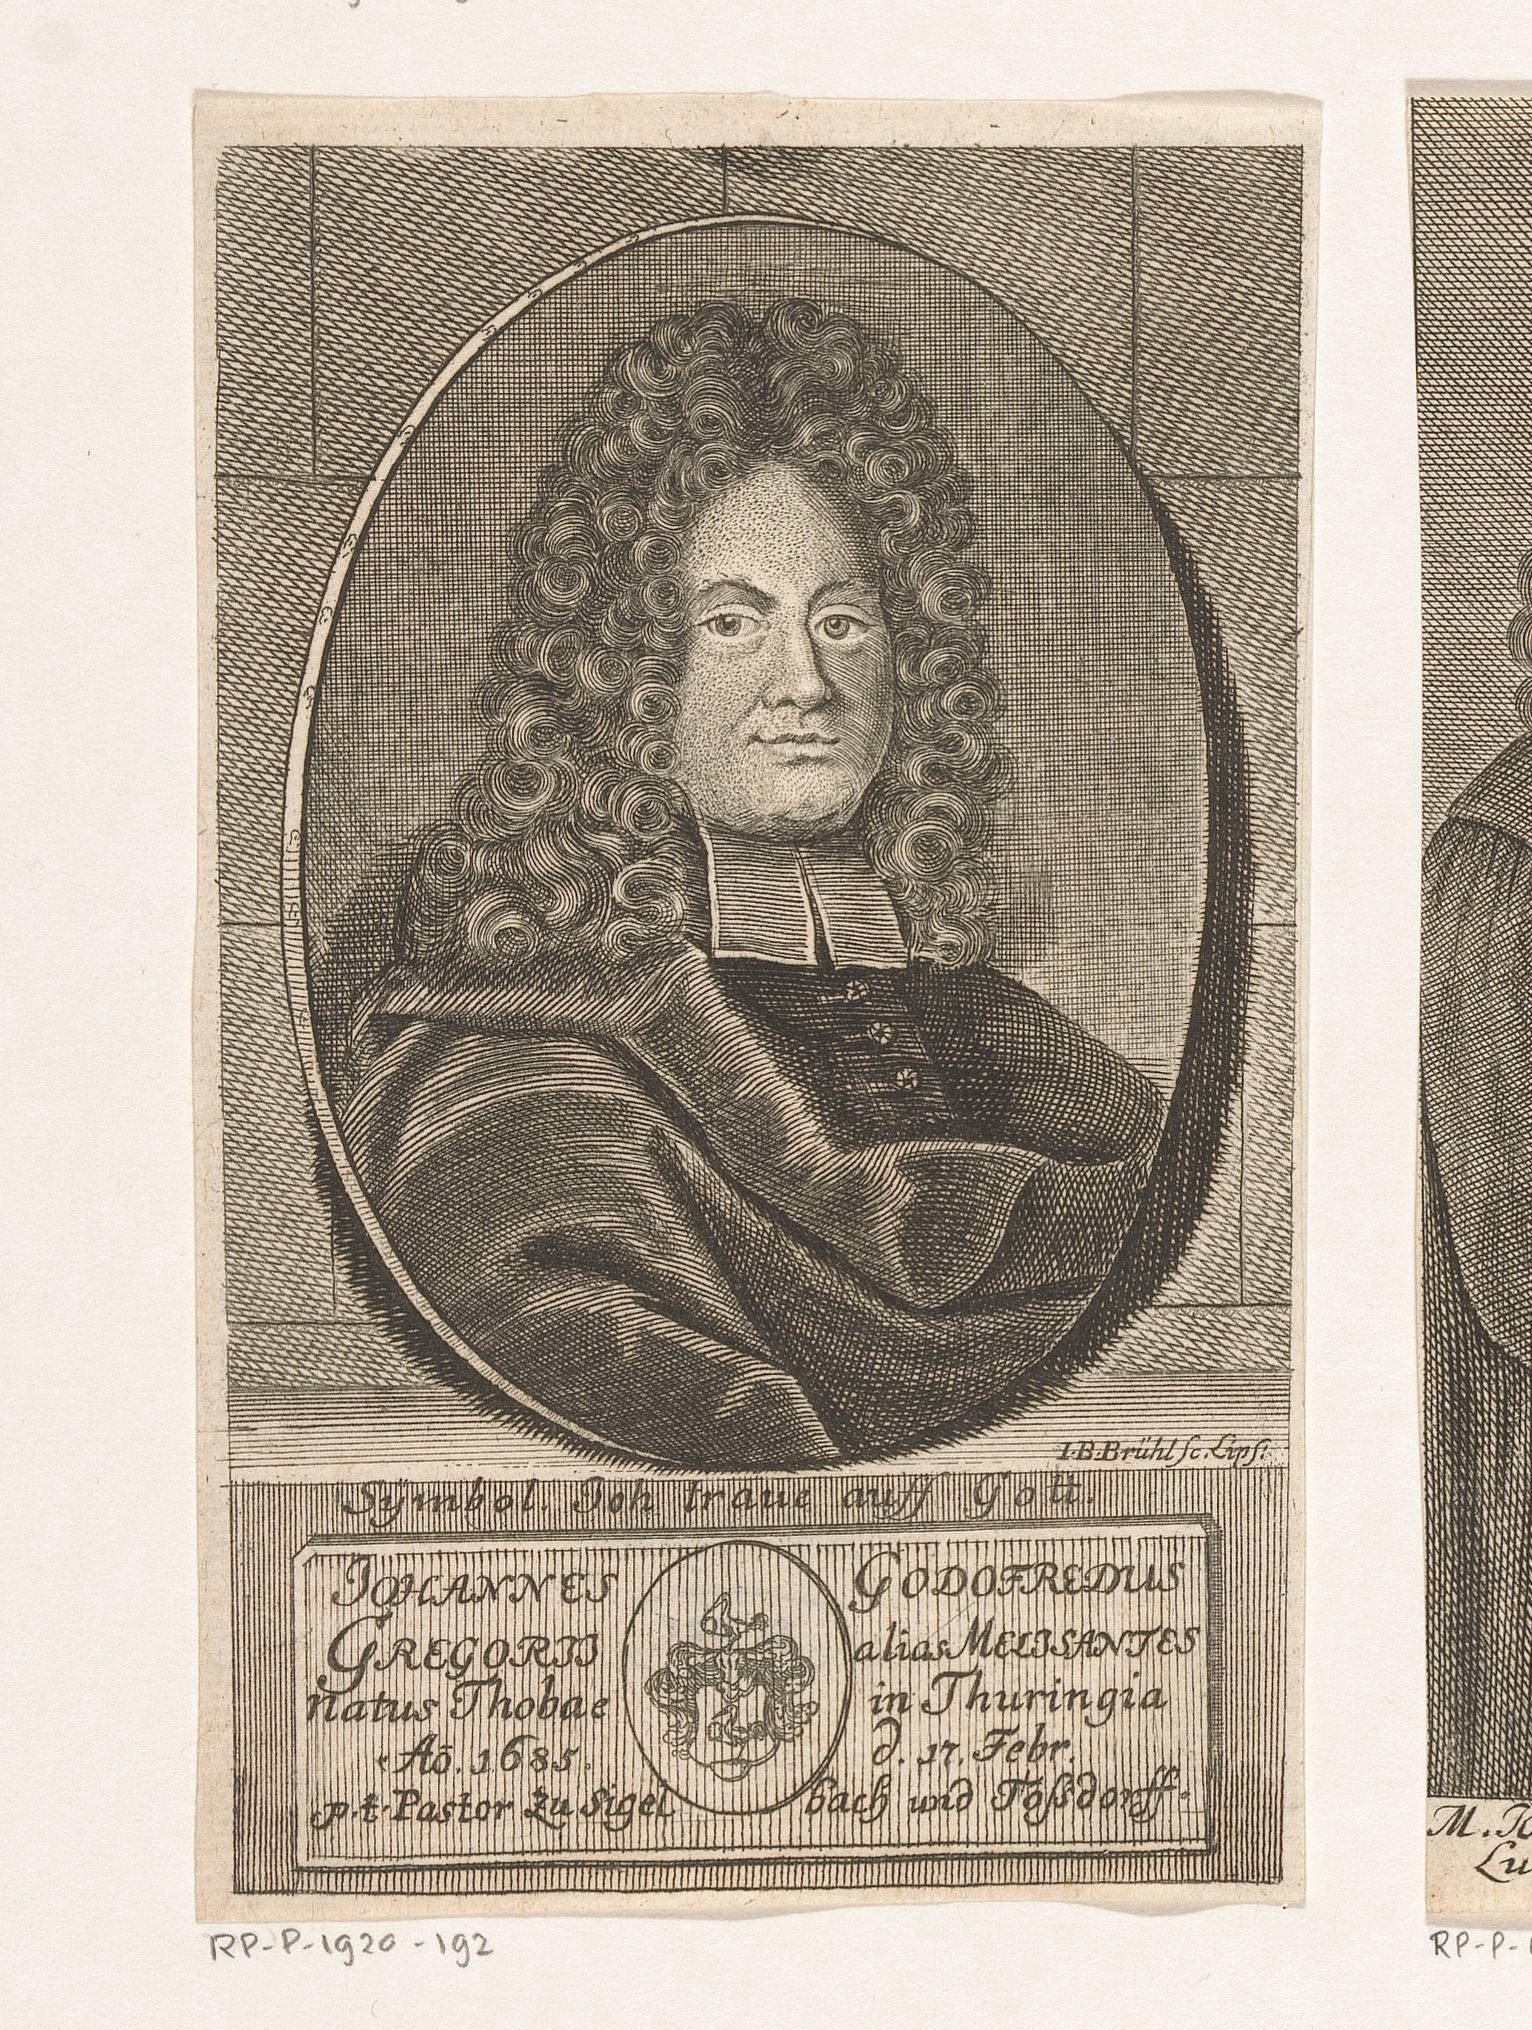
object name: print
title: Portret van Johann Gottfried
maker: johann benjamin brühl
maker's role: print maker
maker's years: 1691-1763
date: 1719-1763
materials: paper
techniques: engraving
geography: leipzig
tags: historical persons, armorial bearing, heraldry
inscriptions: collector's mark: Lugt 2228